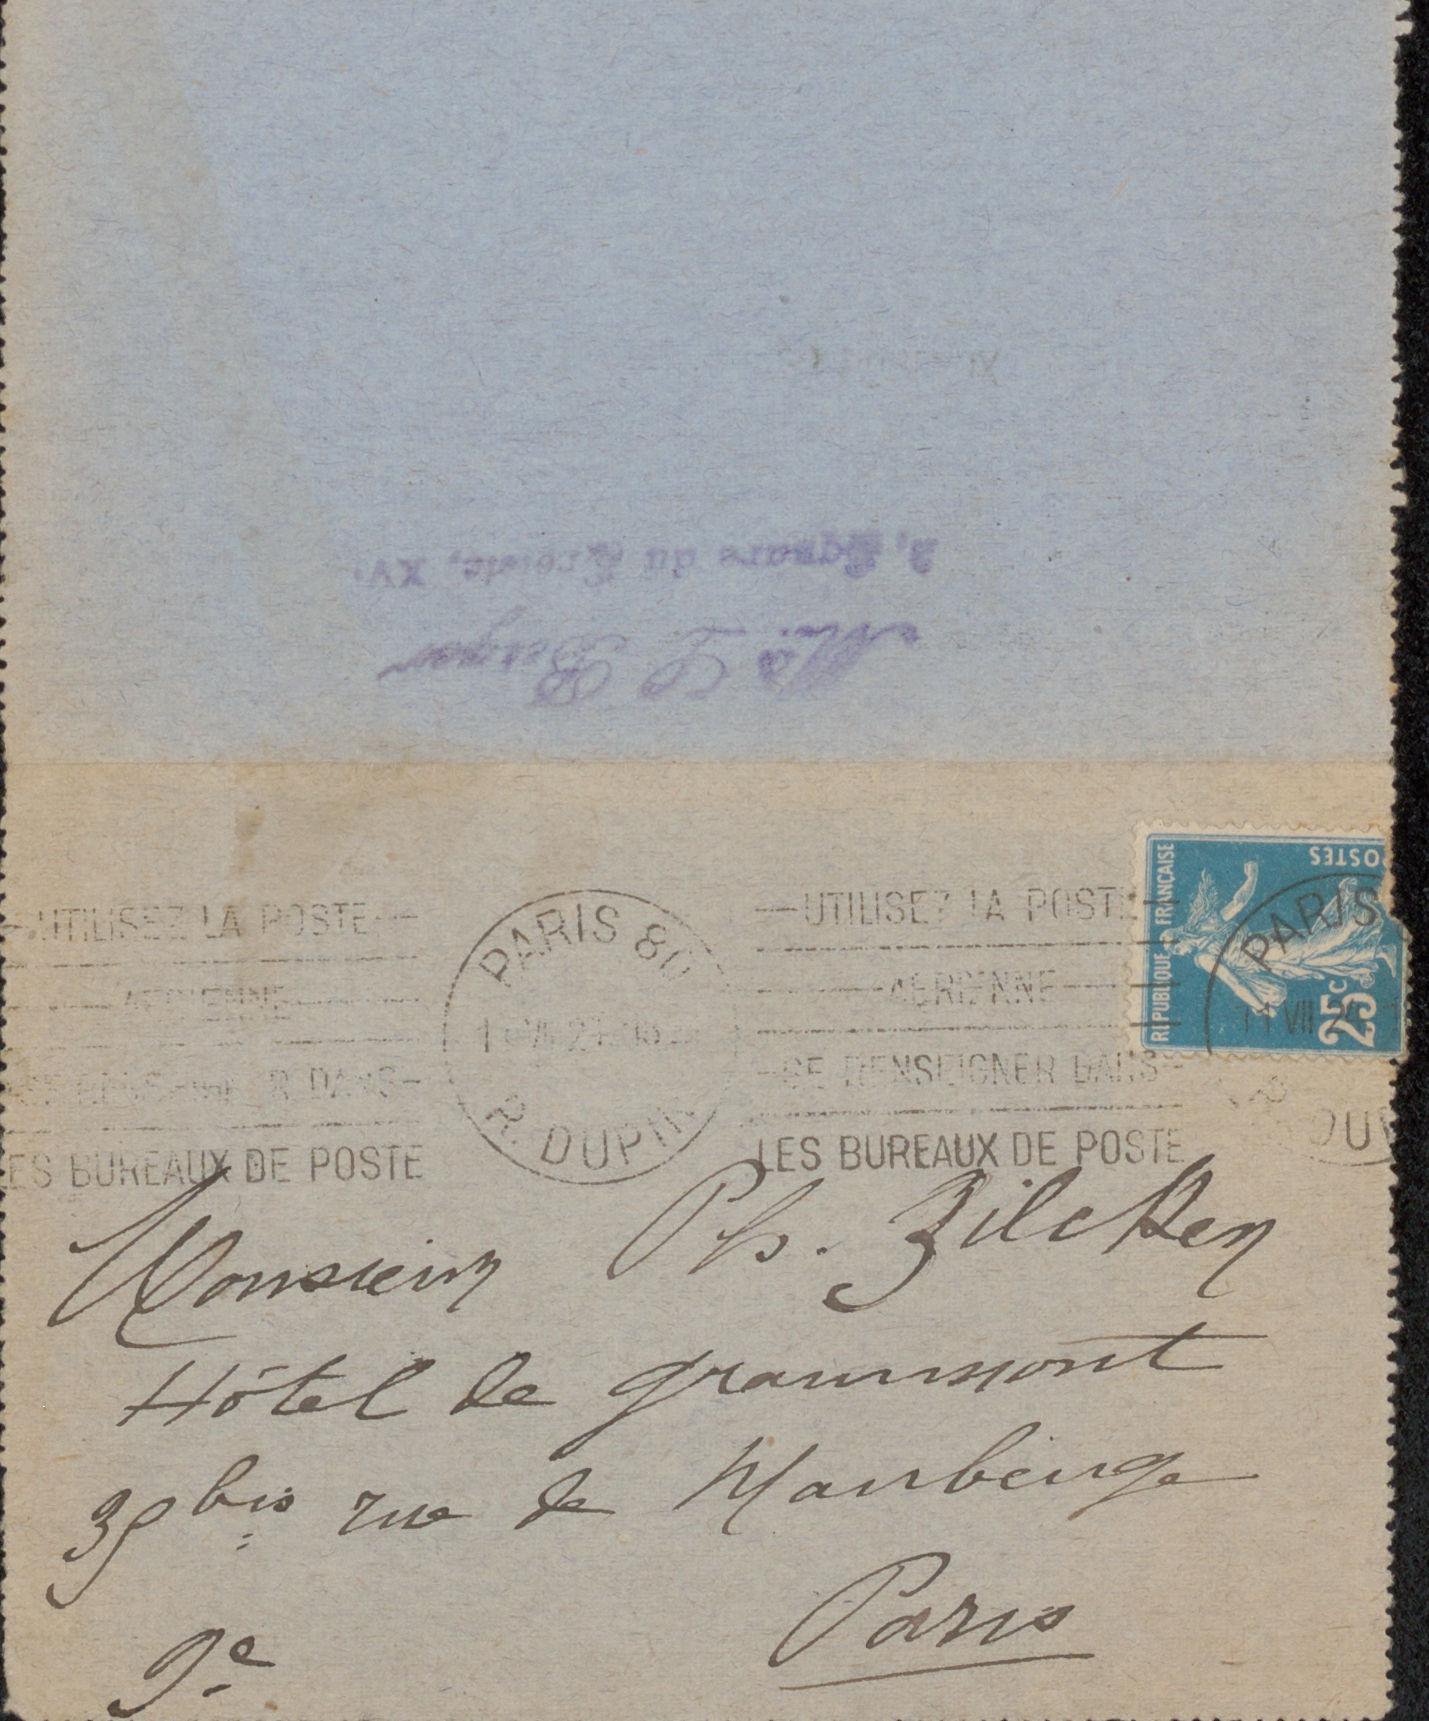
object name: letter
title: Brief aan Philip Zilcken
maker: lya berger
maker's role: schrijver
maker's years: 1877-1941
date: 1924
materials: ink, paper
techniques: pen, writing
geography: paris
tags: the hague, draughtsman, philip zilcken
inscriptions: address: ‘Mlle. L. Berger/ 2, Square du Croisic, XVe’, collector's mark: ‘RPK’